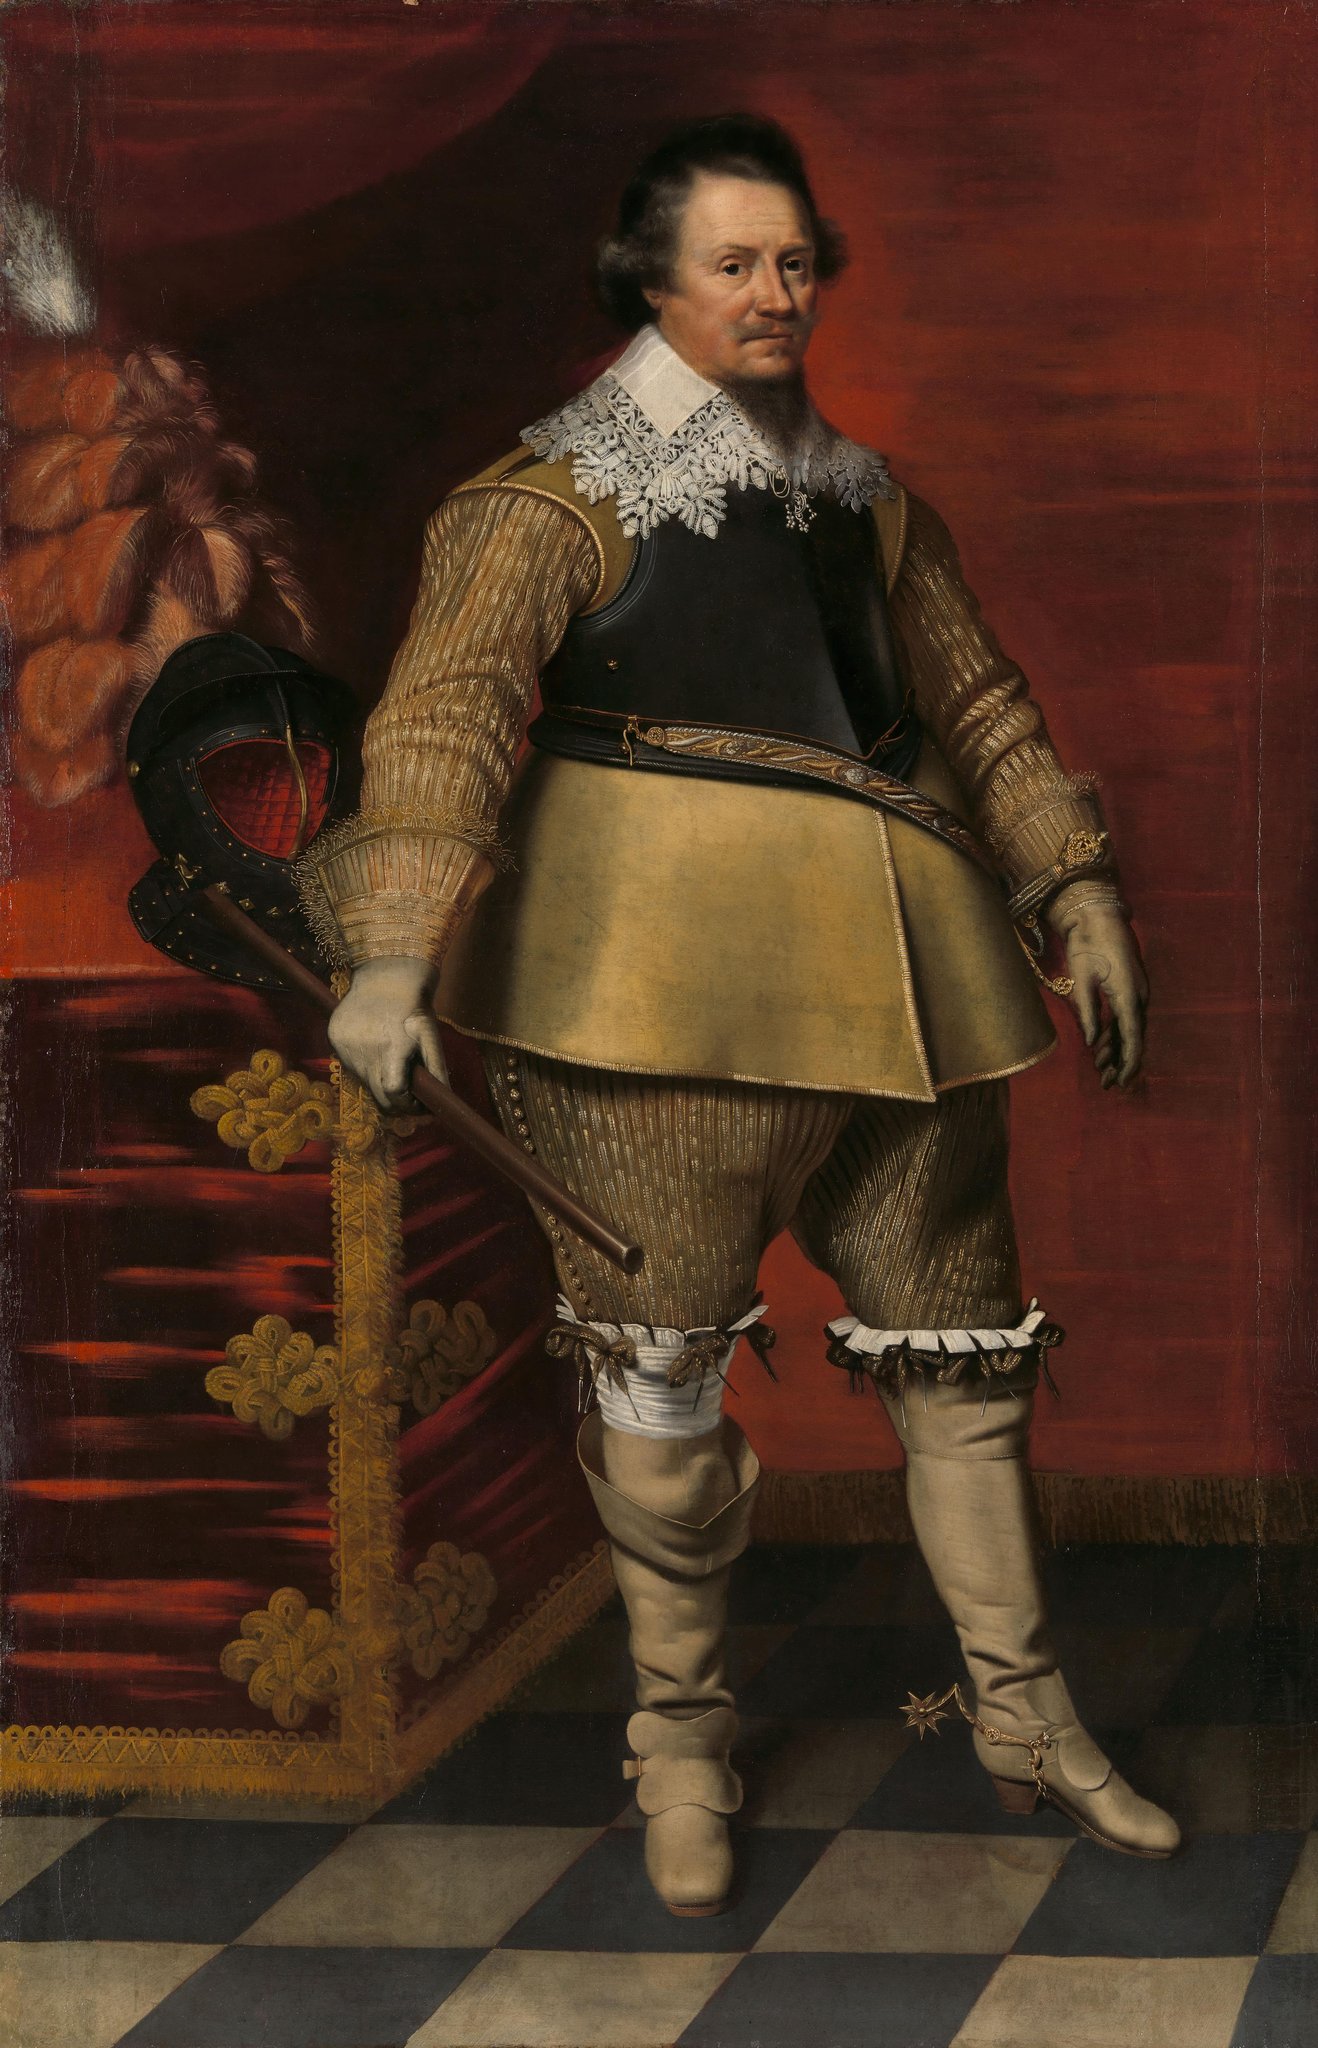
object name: painting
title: Portrait of Ernst Casimir I, Count of Nassau-Dietz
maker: wybrand de geest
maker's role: draughtsman, painter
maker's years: 1592-1665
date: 1630-1635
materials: canvas, oil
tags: ernst casimir graaf van nassau-dietz, historical persons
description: The stadholders of Friesland were not the descendants of William of Orange, but of his brother Jan. Ernst Casimir, Janâ€™s son, moreover, was also stadholder of Groningen and Drenthe. He is shown here in military regalia, with a buff jerkin, cuirass, boots with spurs, and a staff of office. The style of the clothing suggests that the portrait originated around 1630; it could have been painted after his violent death in 1632.